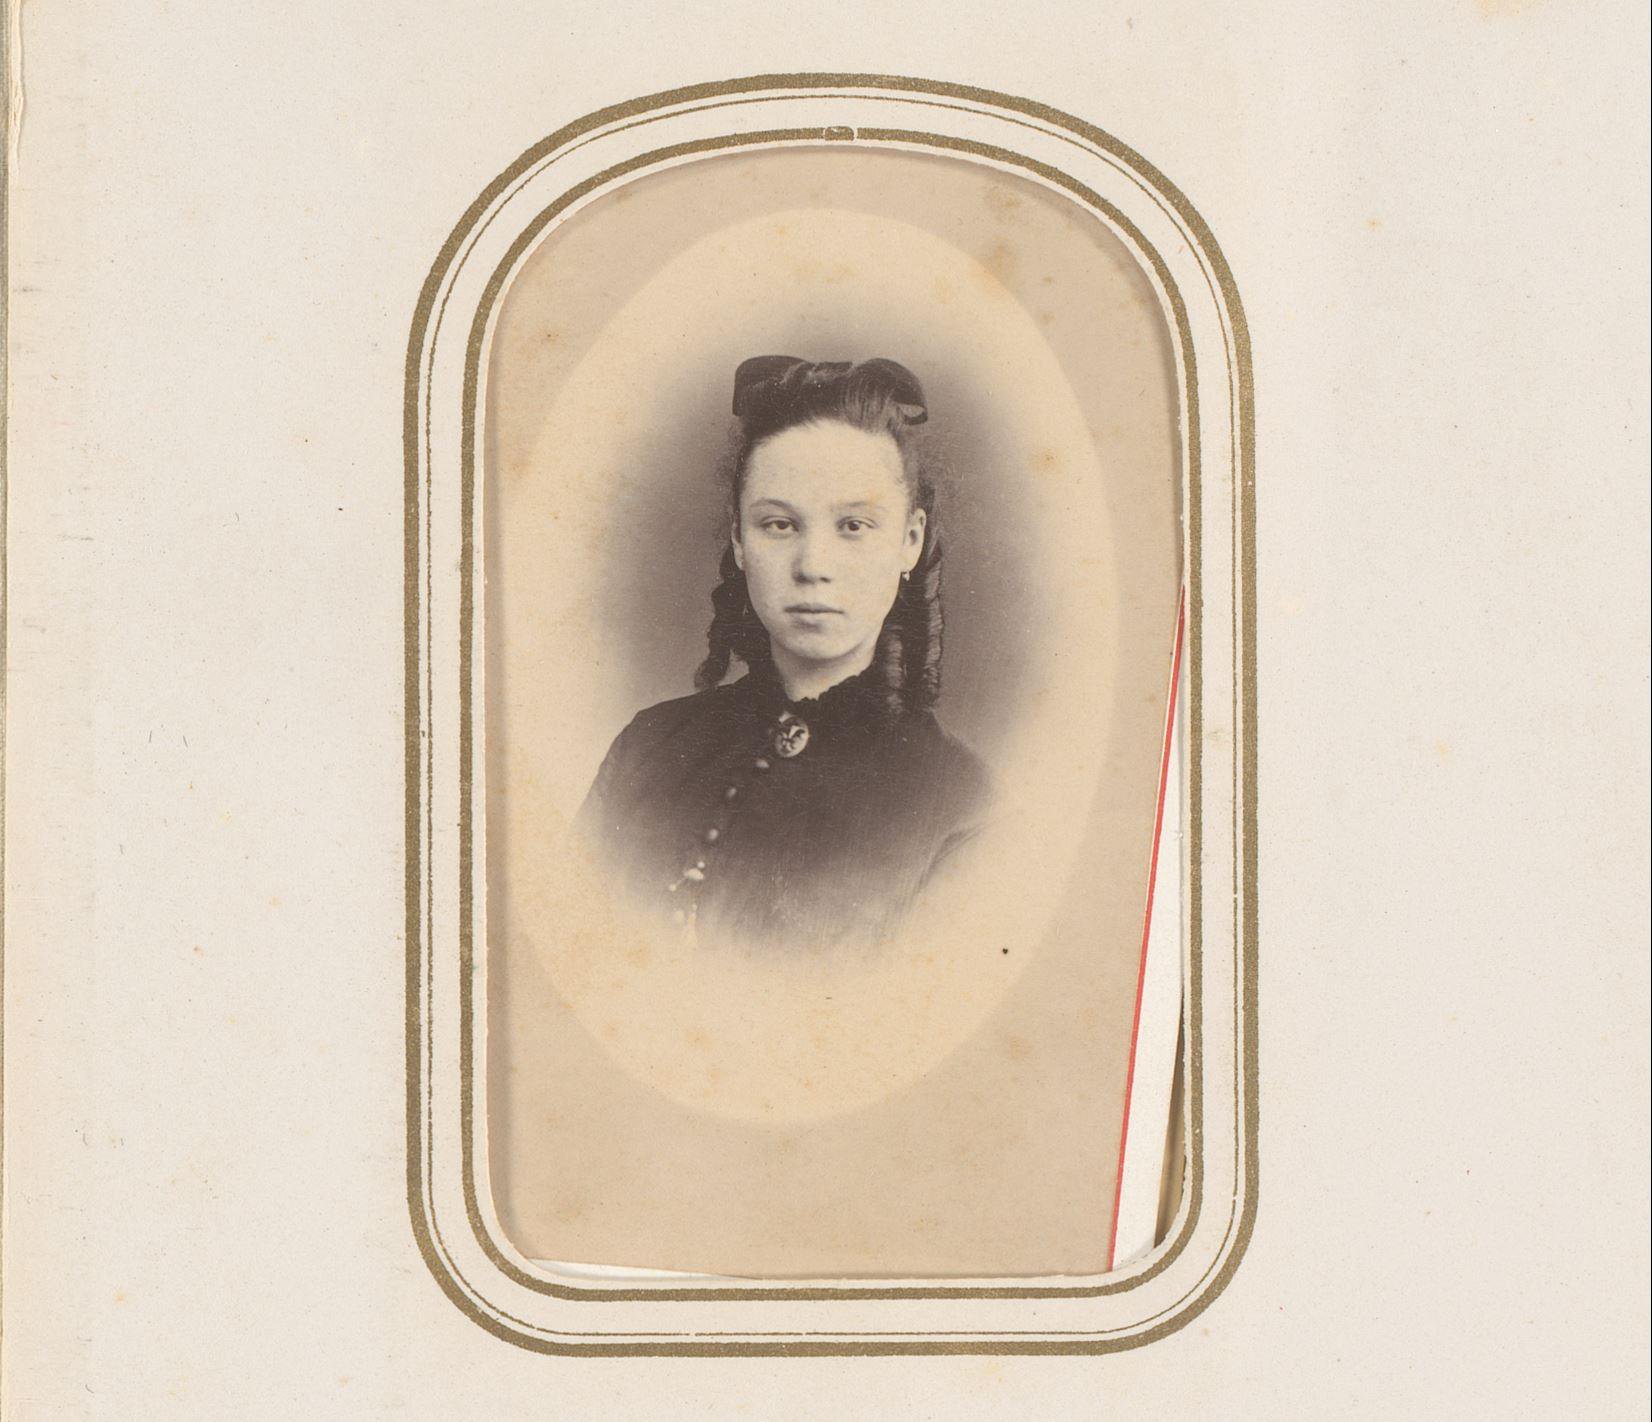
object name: carte de visite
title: Portret van een jonge vrouw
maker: Anonymous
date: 1850-1890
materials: cardboard, photographic support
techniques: albumen print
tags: adolescent, young woman, maiden, historical persons